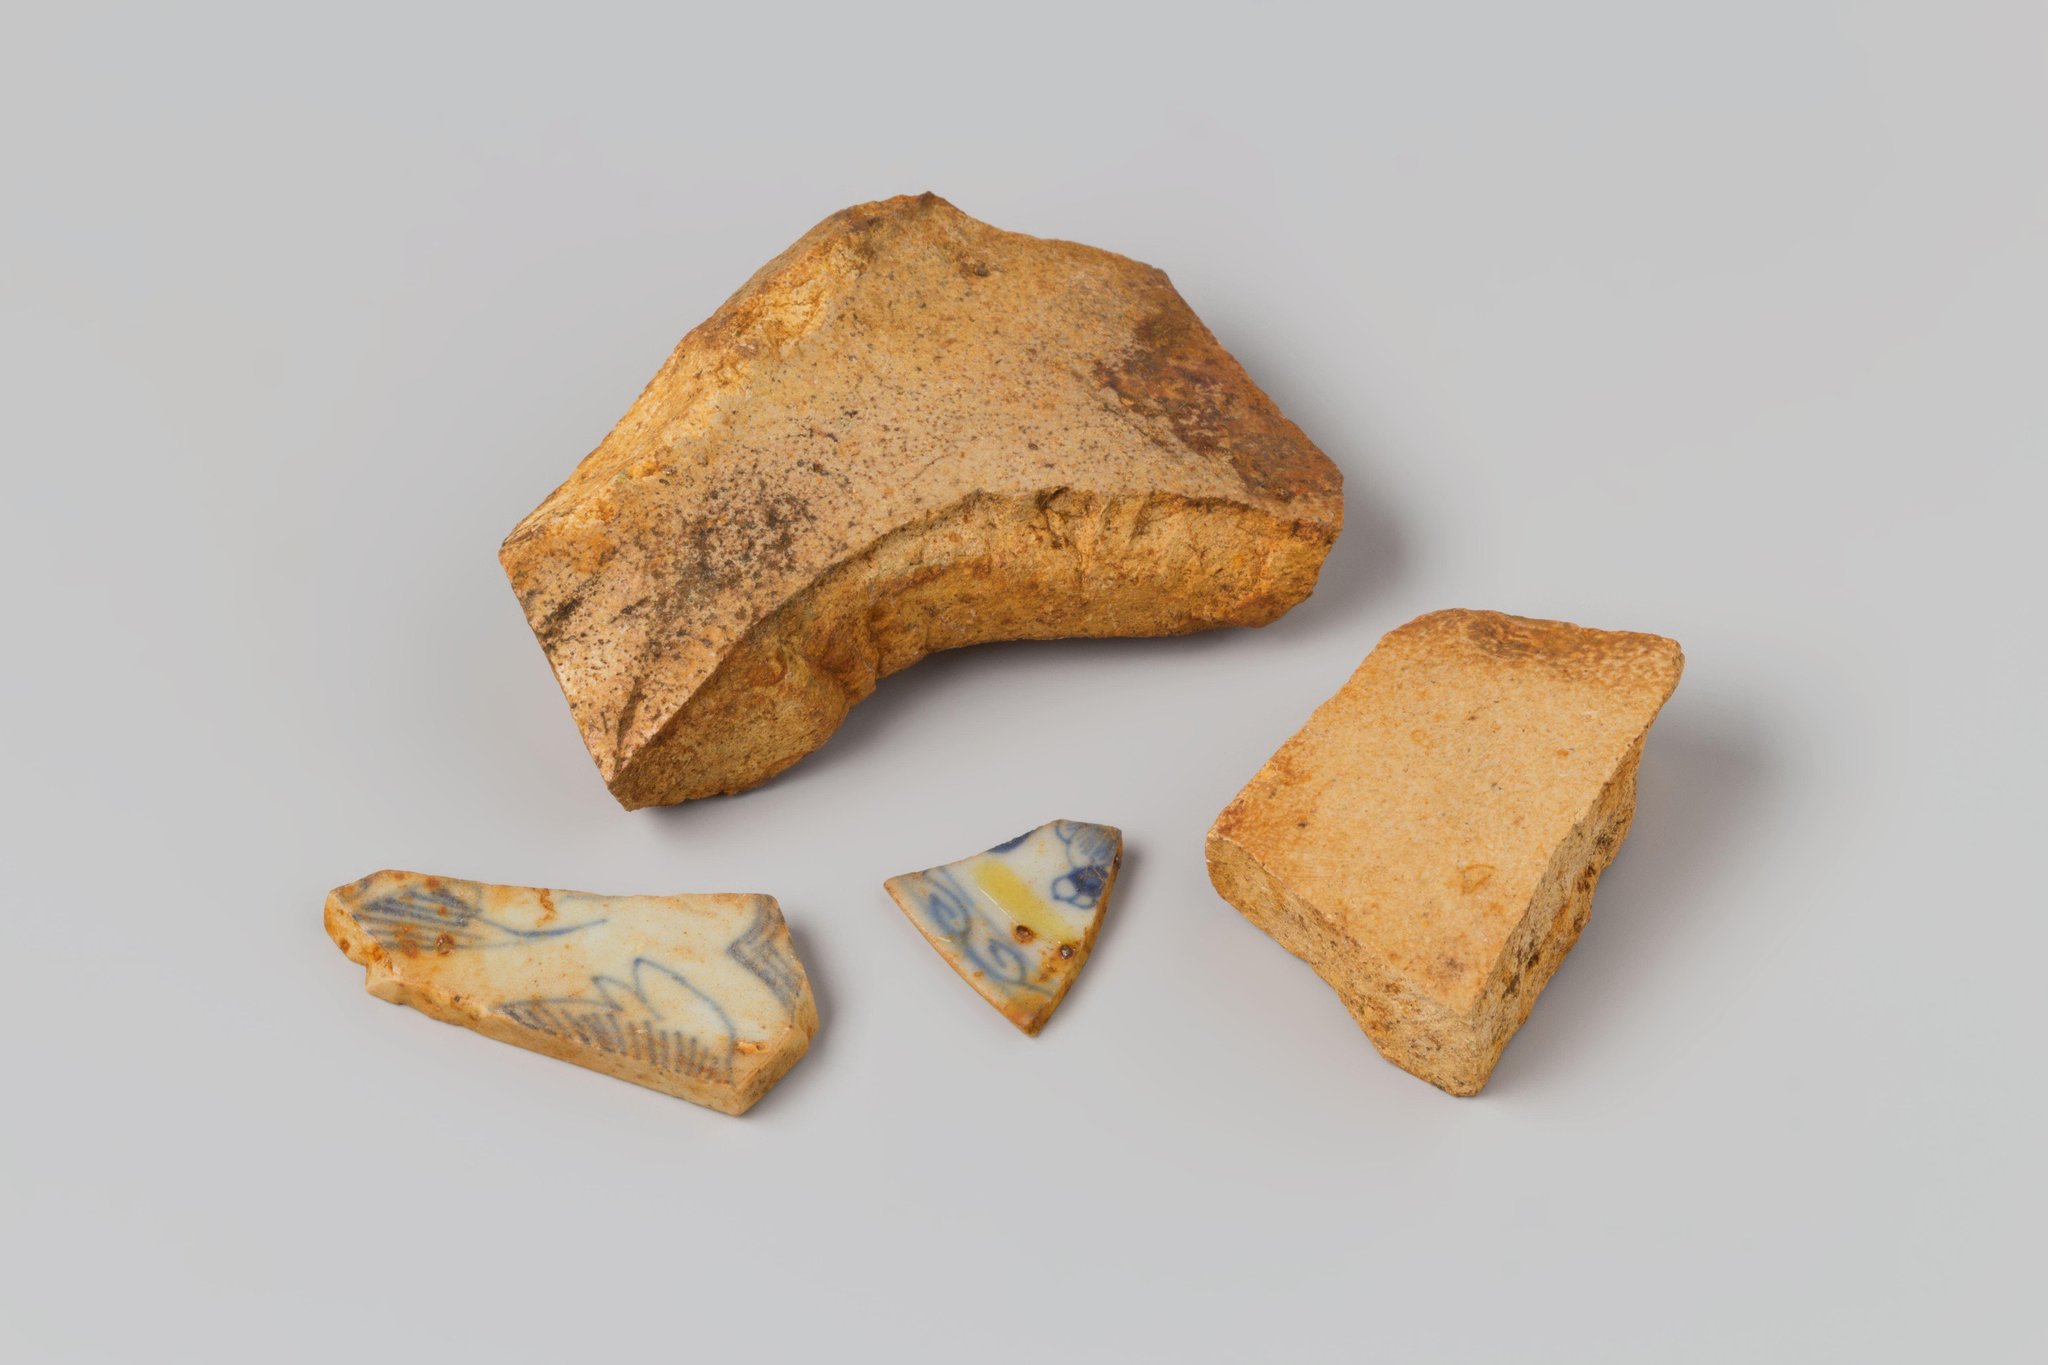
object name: sherd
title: Scherven van porselein en steengoed uit het wrak van de Oost-Indiëvaarder Hollandia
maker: Anonymous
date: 1700-1743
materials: porcelain, stoneware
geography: cologne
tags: verenigde oostindische compagnie, hollandia (schip), annet